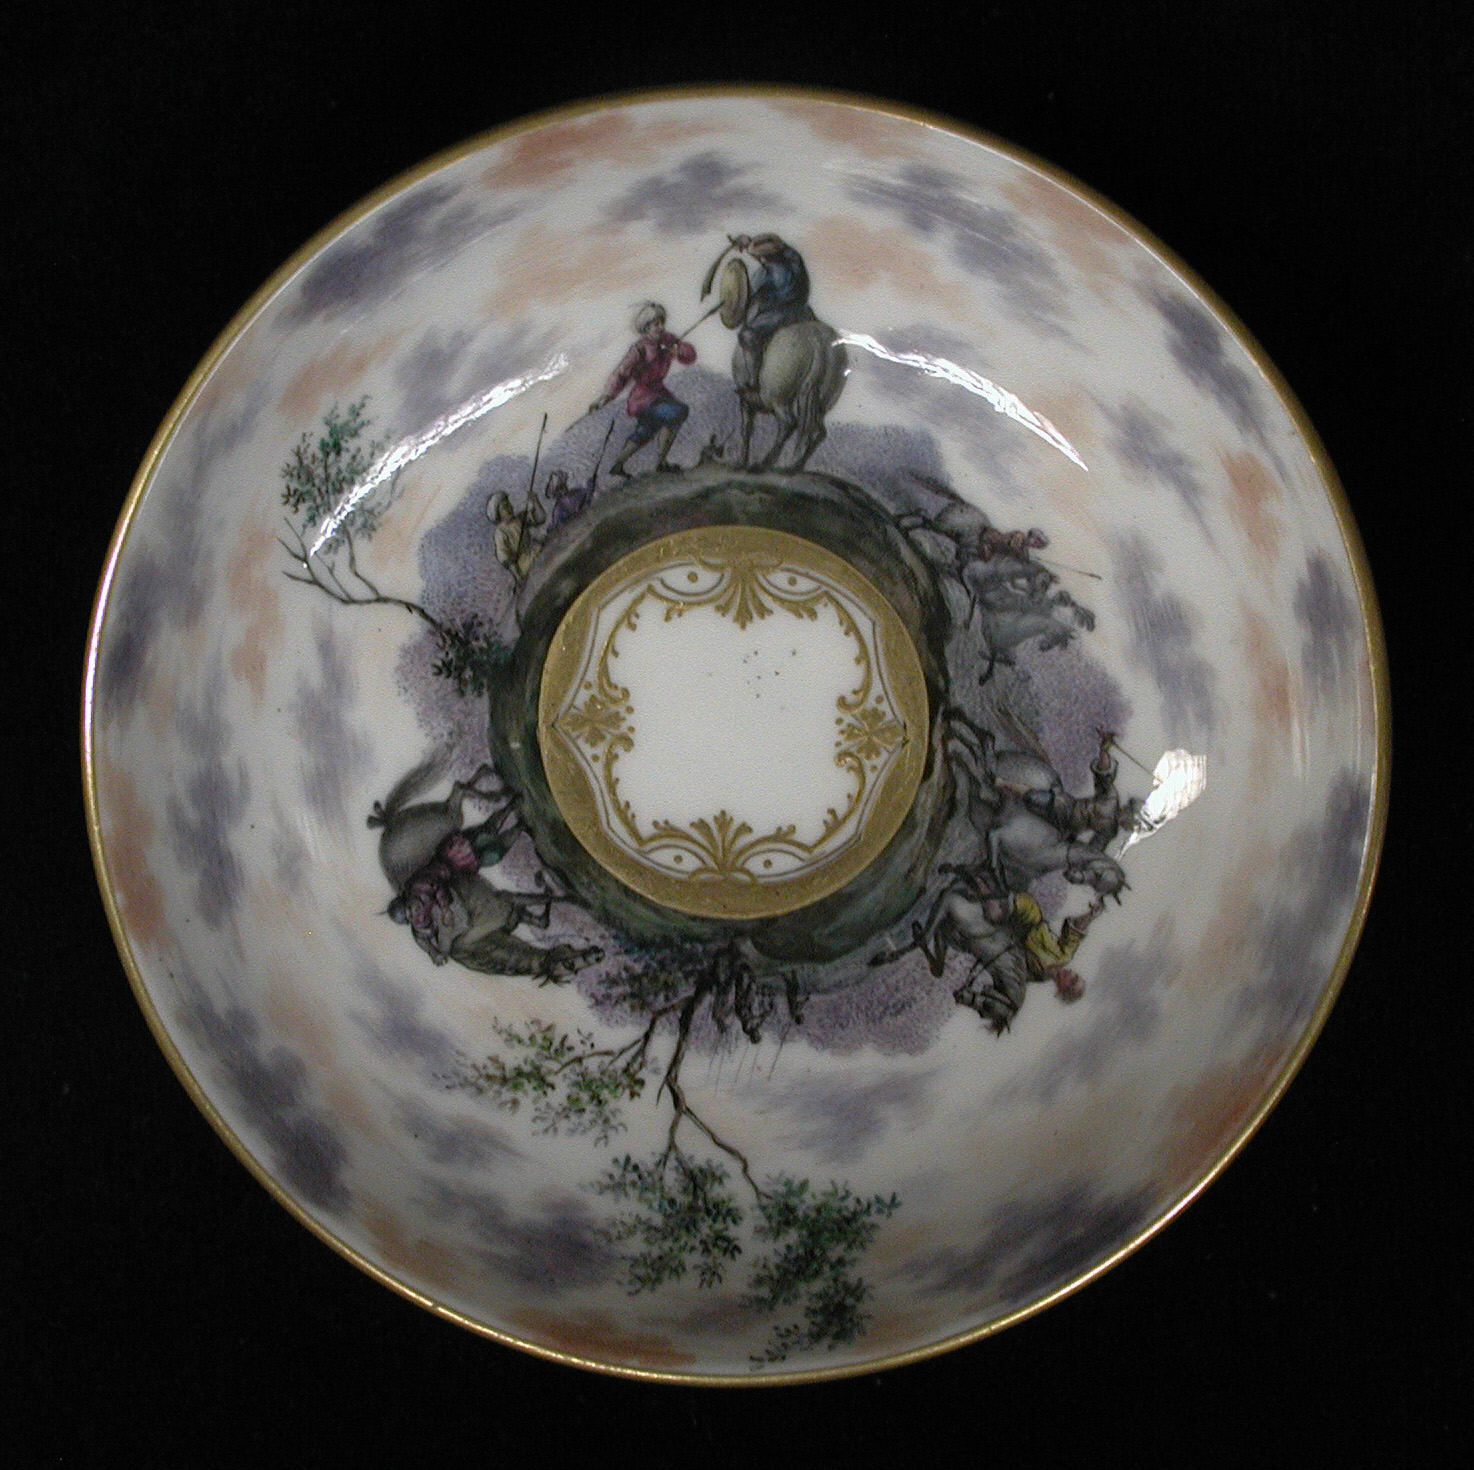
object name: saucer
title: Saucer (part of a service)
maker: capodimonte porcelain manufactory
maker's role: manufactory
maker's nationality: italian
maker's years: 1740-1759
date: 1743-1759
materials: soft paste porcelain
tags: men,horses